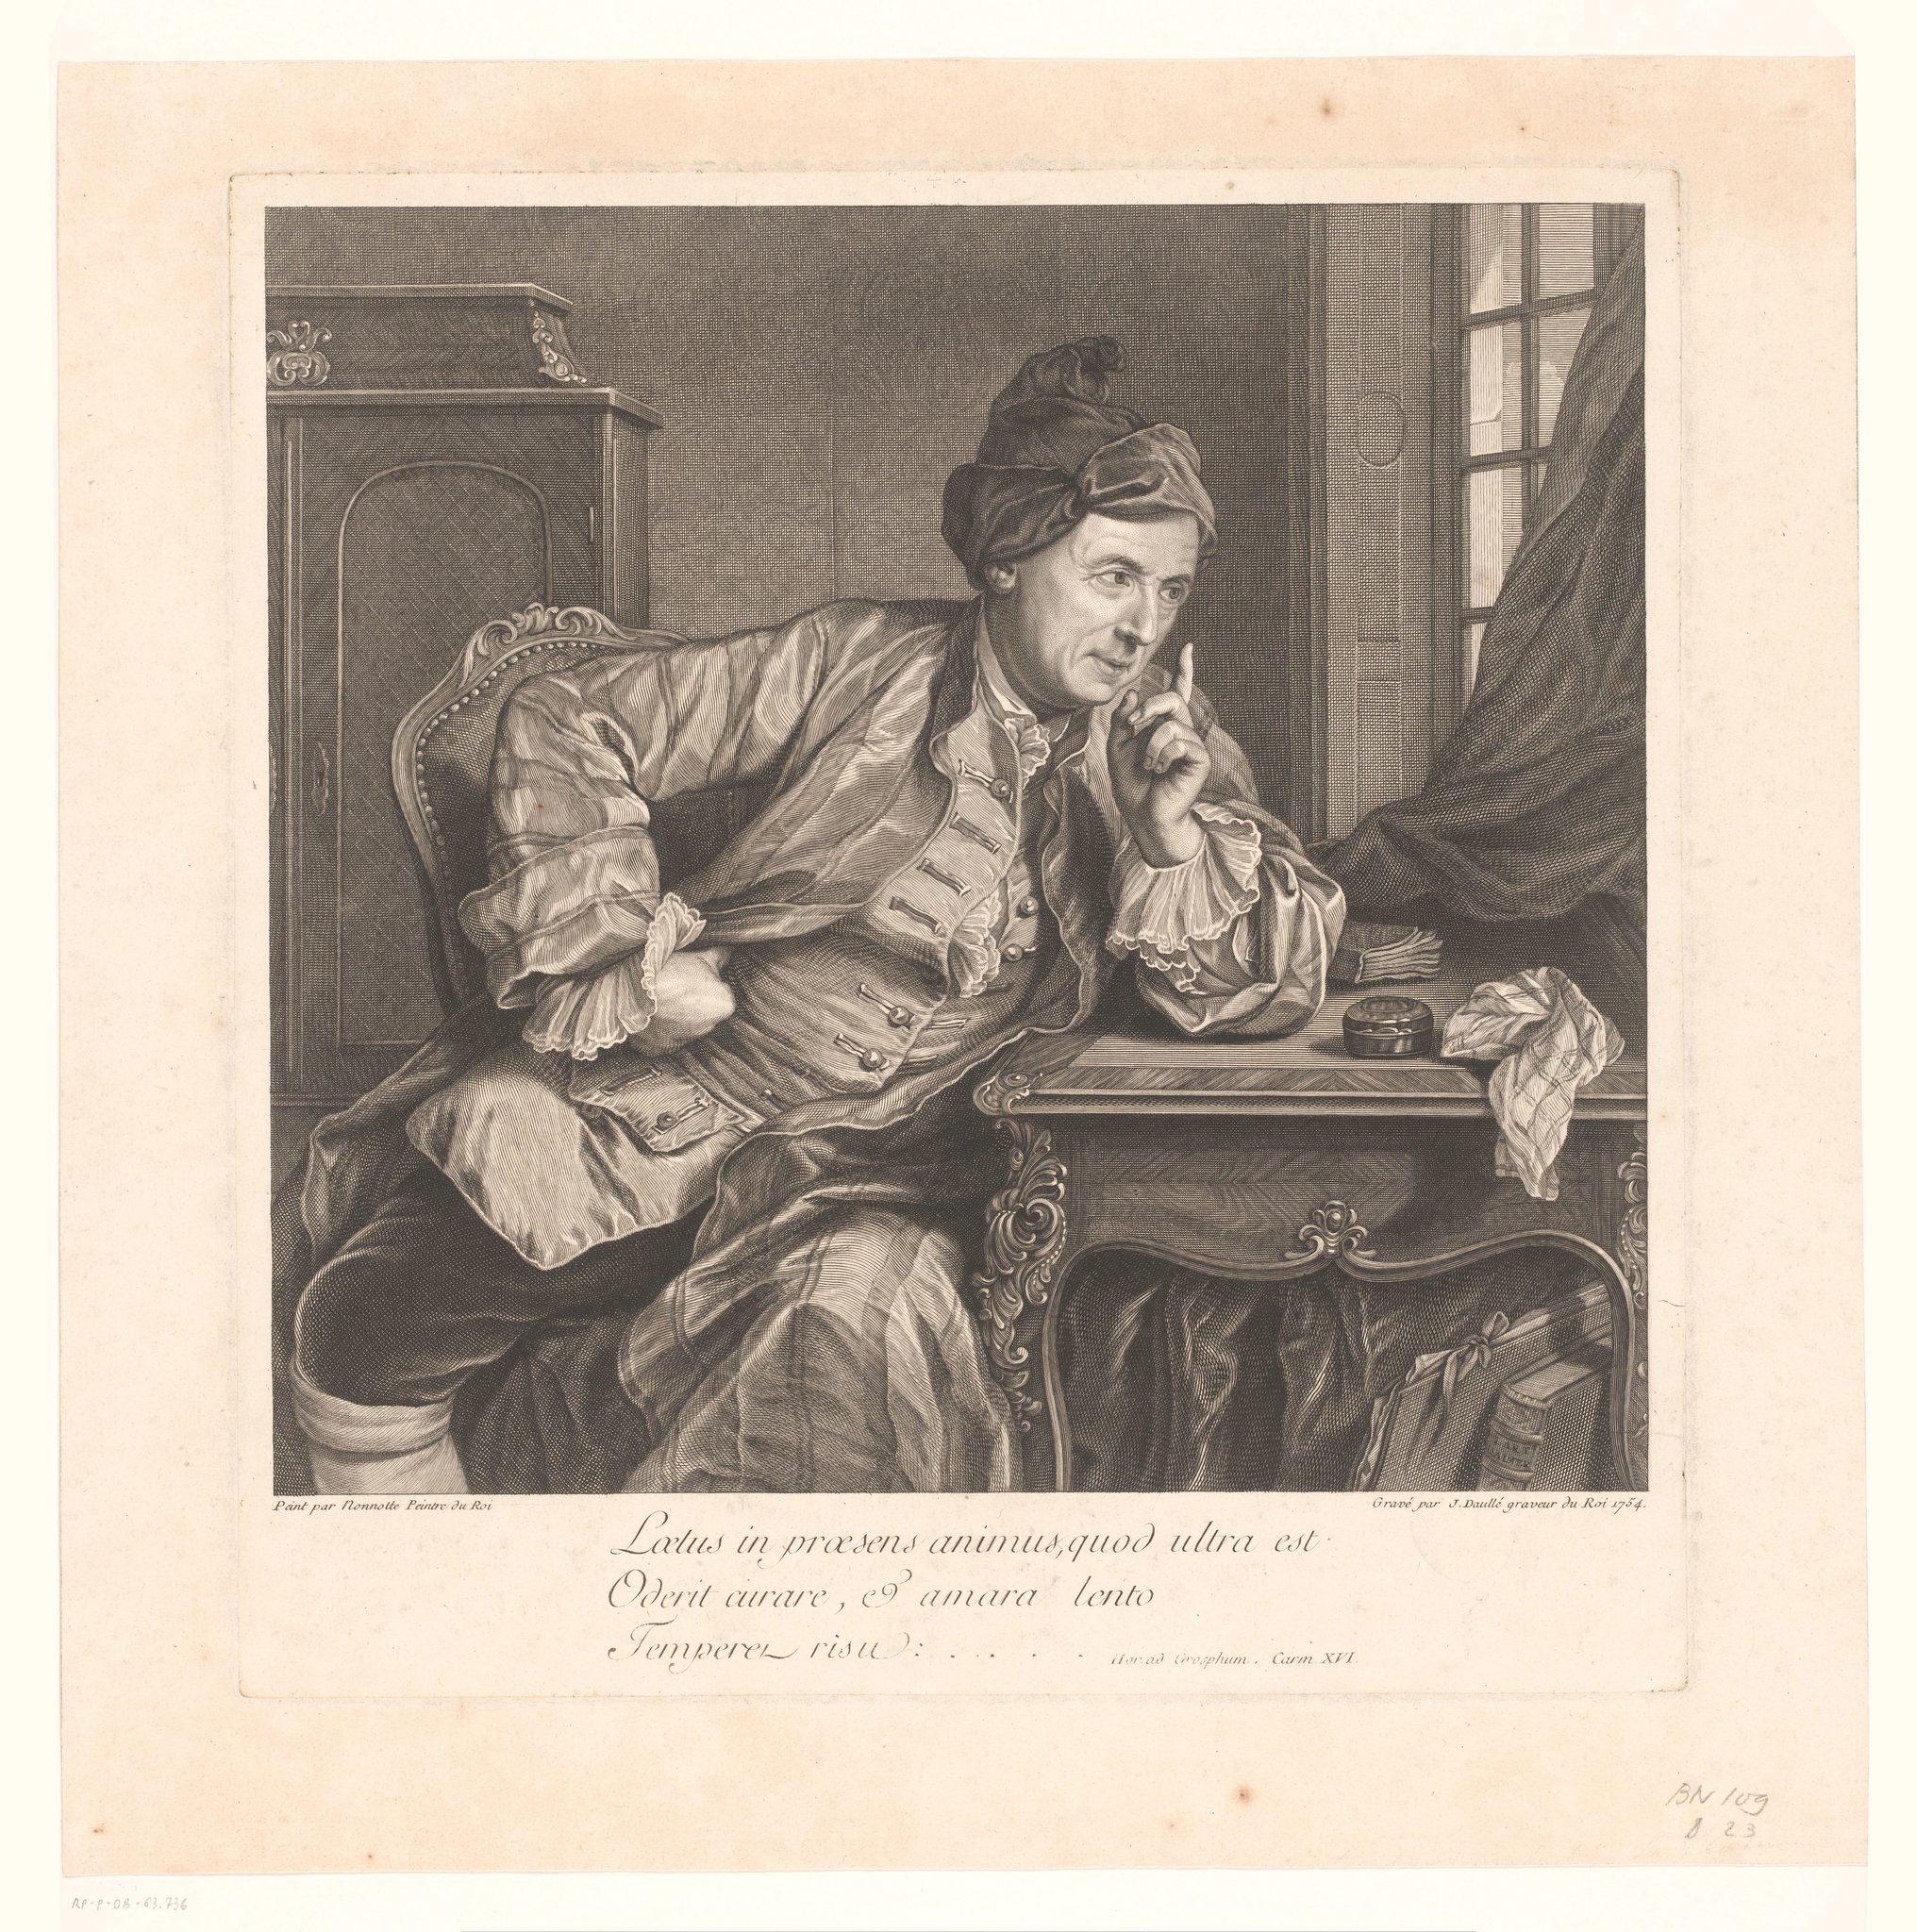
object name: print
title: Portret van Jean Vincent Capronnier de Gauffecourt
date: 1754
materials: paper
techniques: engraving, etching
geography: france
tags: historical persons, printer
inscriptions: collector's mark: Lugt 240